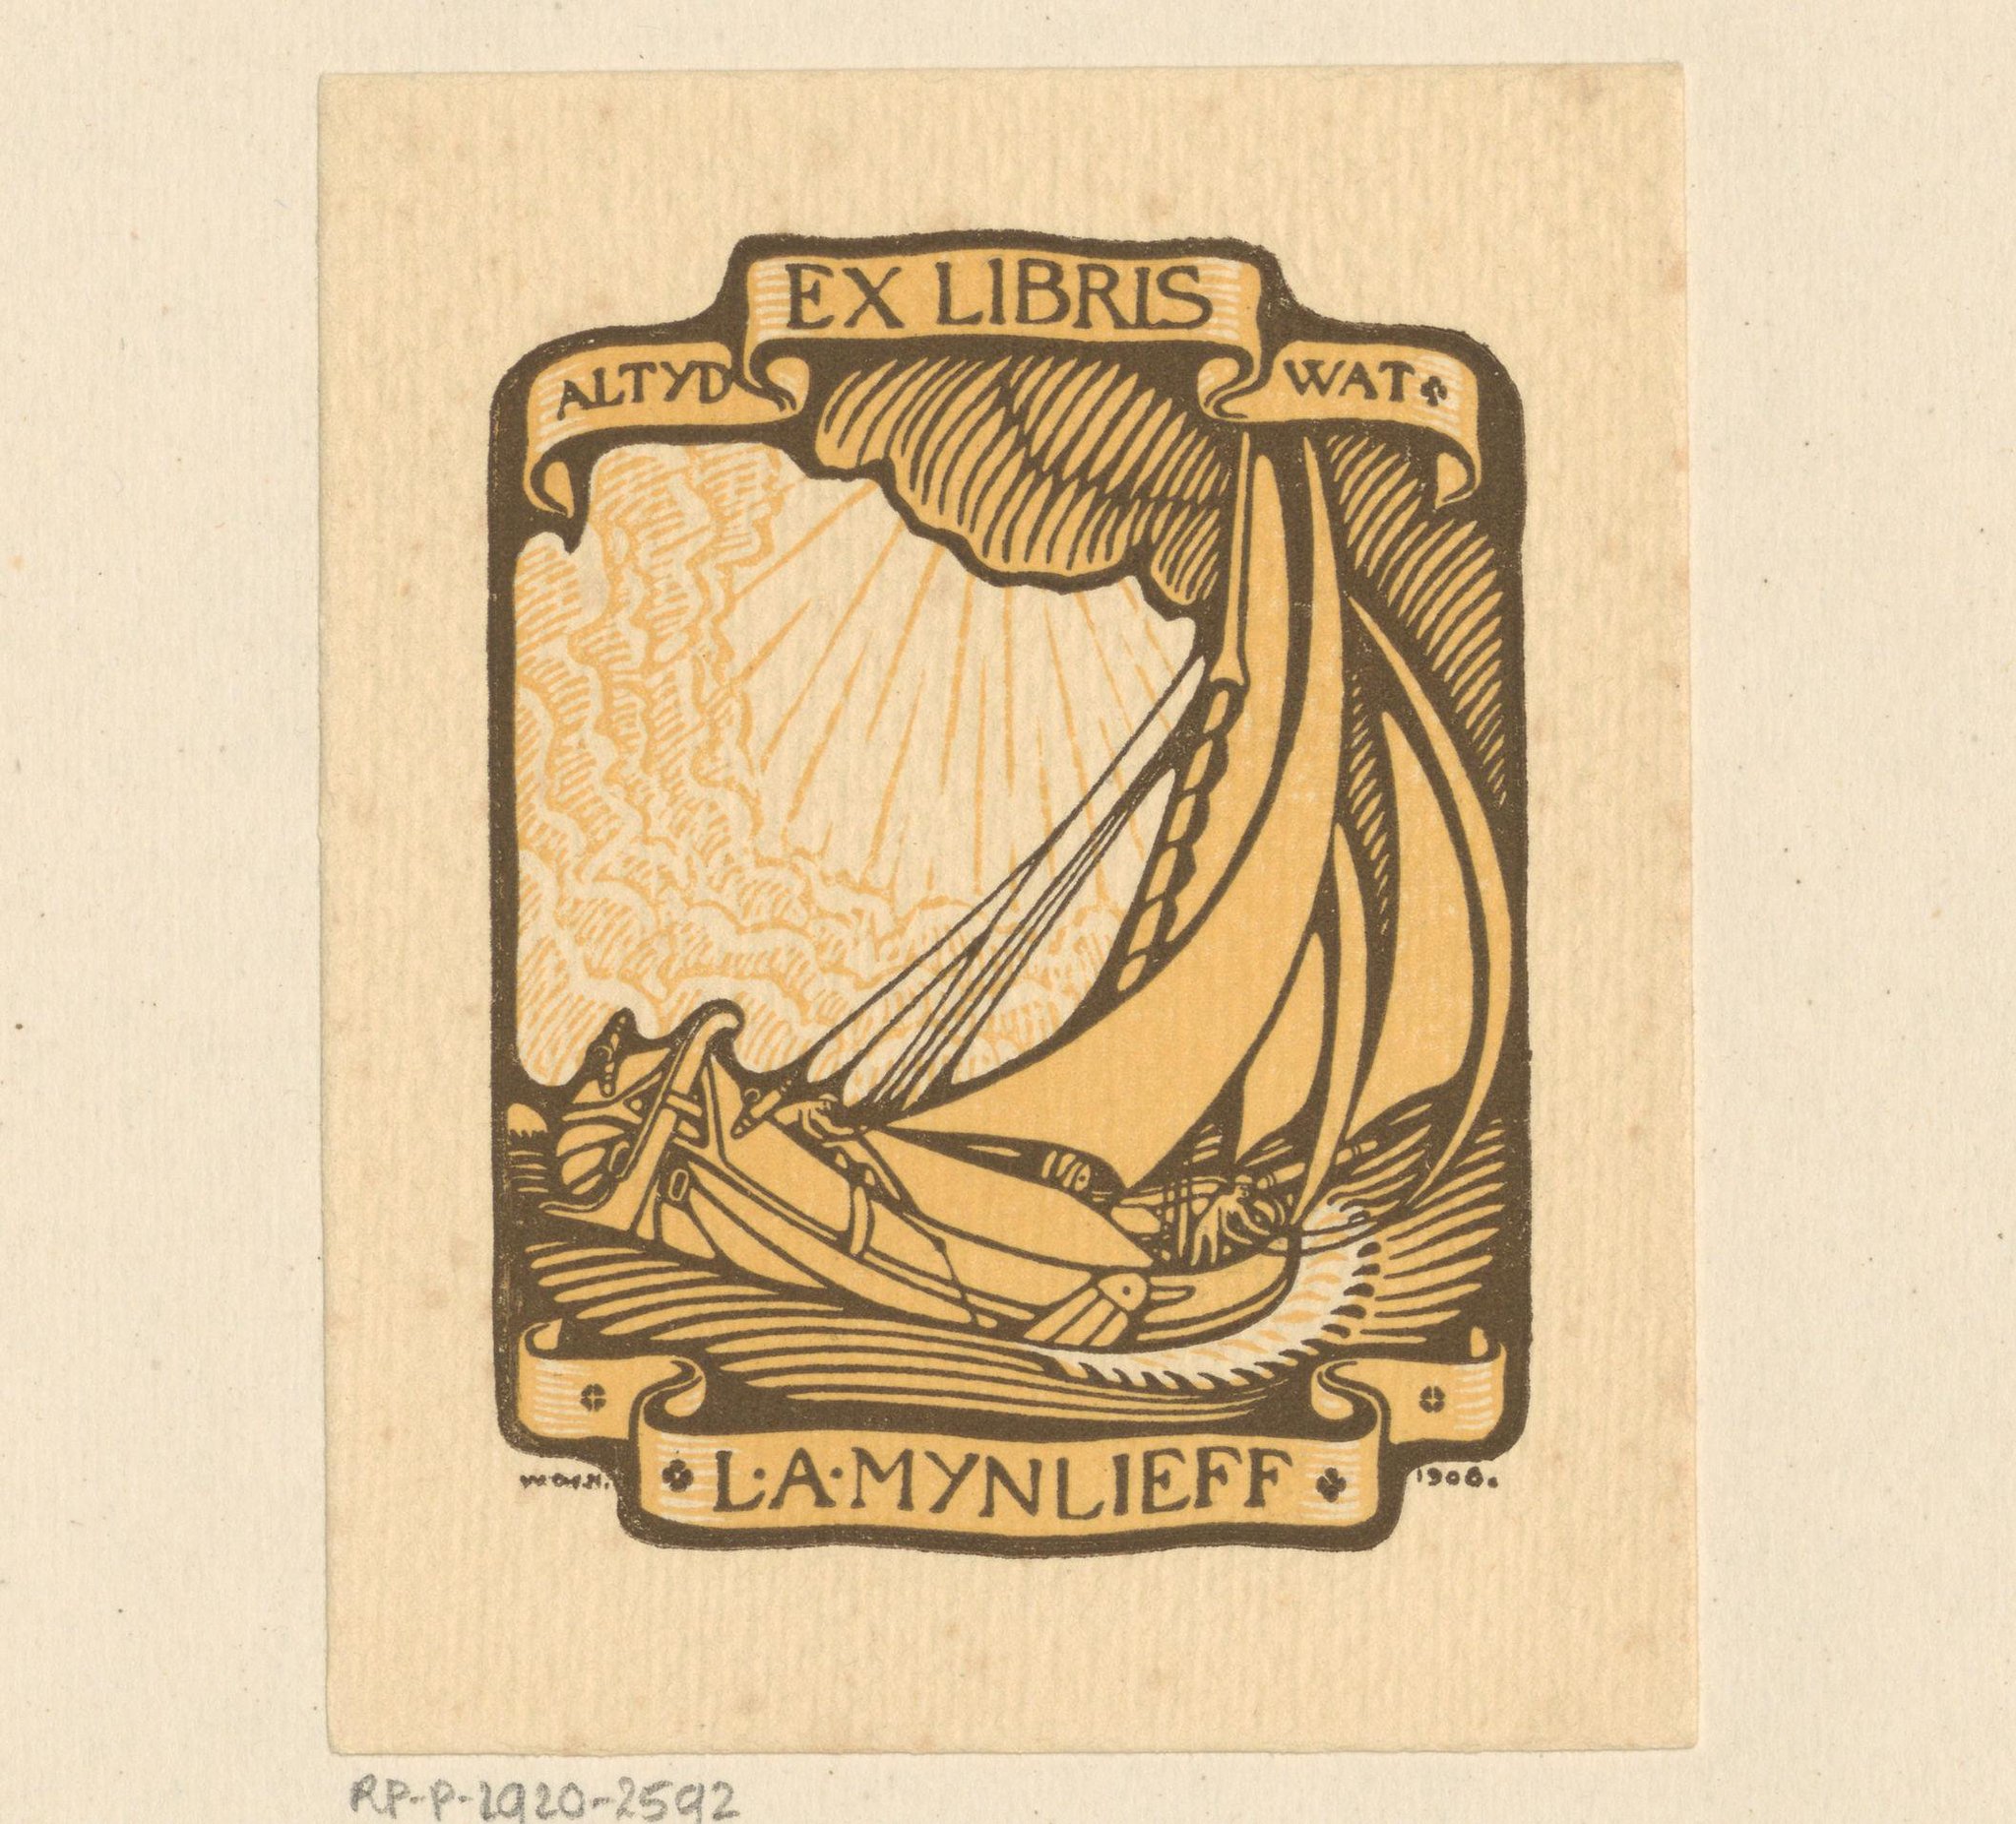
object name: bookplate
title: Ex libris van L.A. Mijnlieff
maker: wijnand otto jan nieuwenkamp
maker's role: draughtsman, print maker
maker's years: 1874-1950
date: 1908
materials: paper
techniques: printing block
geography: netherlands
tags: sailing-ship, sailing-boat, sunbeams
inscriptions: collector's mark: Lugt 2233